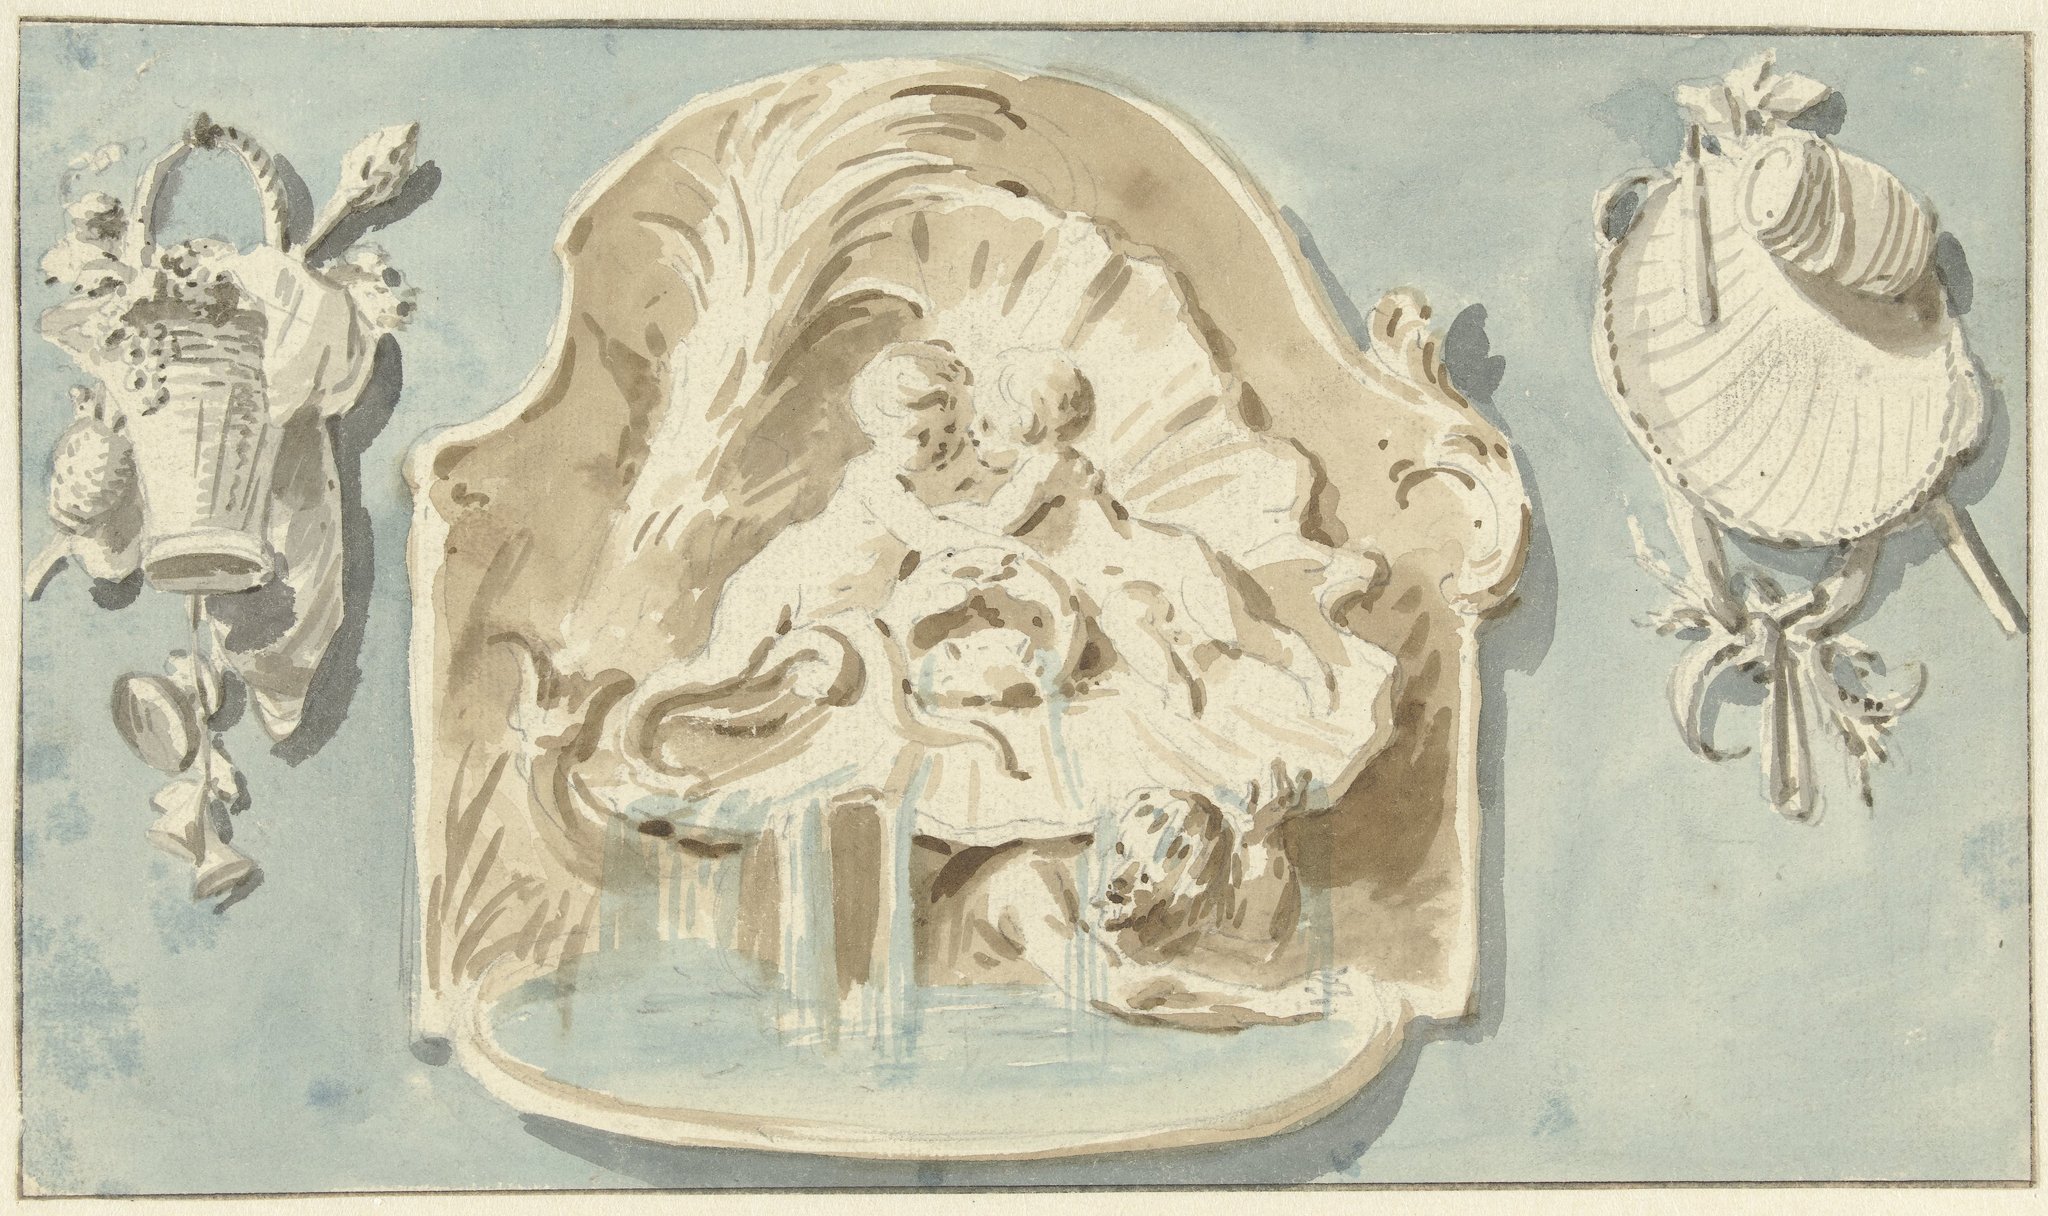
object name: drawing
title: Ornament van fonteintje en twee trofeeën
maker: Anonymous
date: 1700-1800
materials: paper, pencil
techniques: brush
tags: piece of sculpture, reproduction of a piece of sculpture